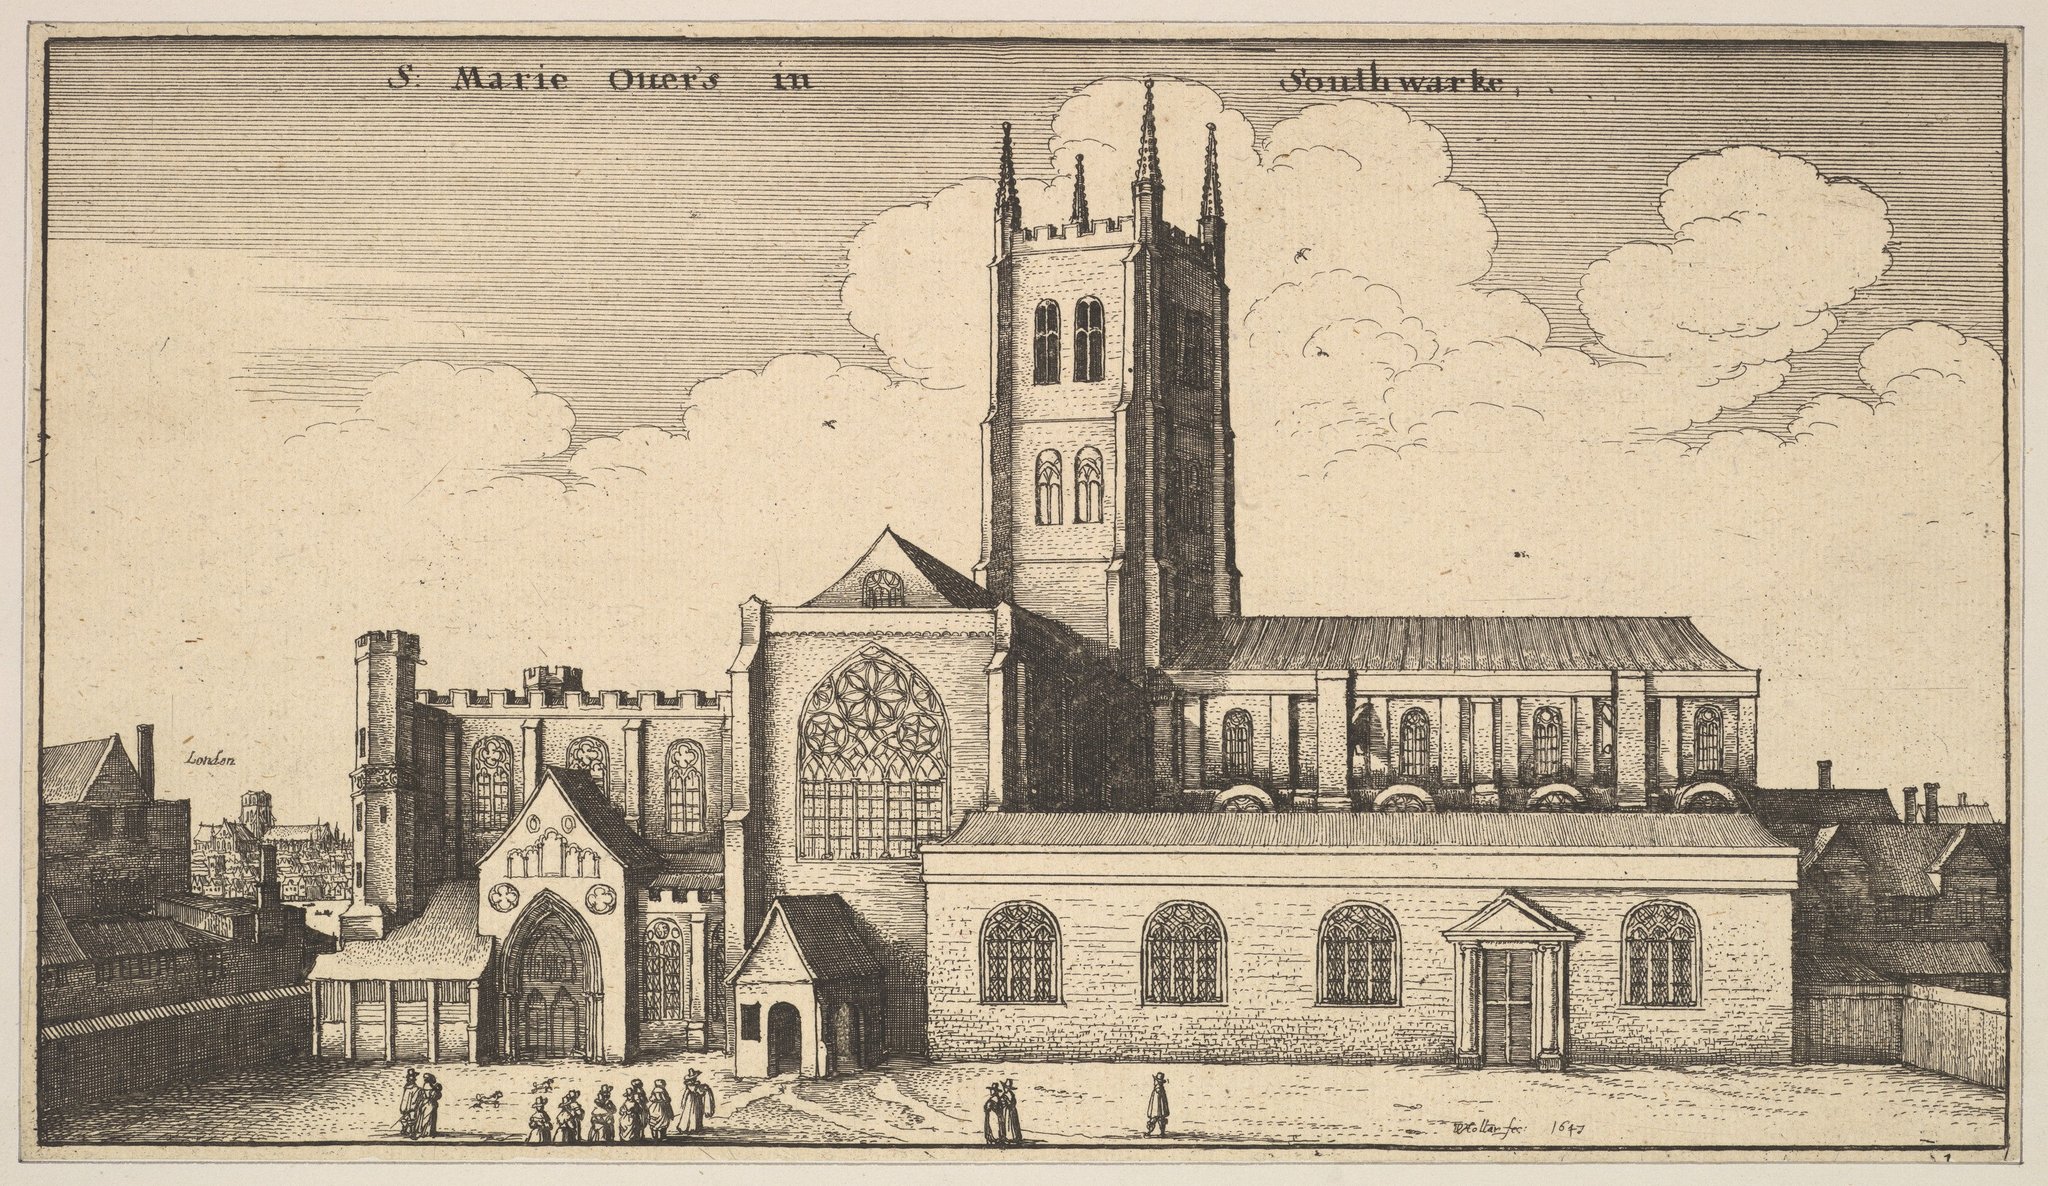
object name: print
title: S. Marie Overs in Southwarke (St. Mary Overy, now Southwark Cathedral)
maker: wenceslaus hollar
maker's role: artist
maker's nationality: bohemian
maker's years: 1607-1677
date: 1647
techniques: etching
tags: human figures,churches